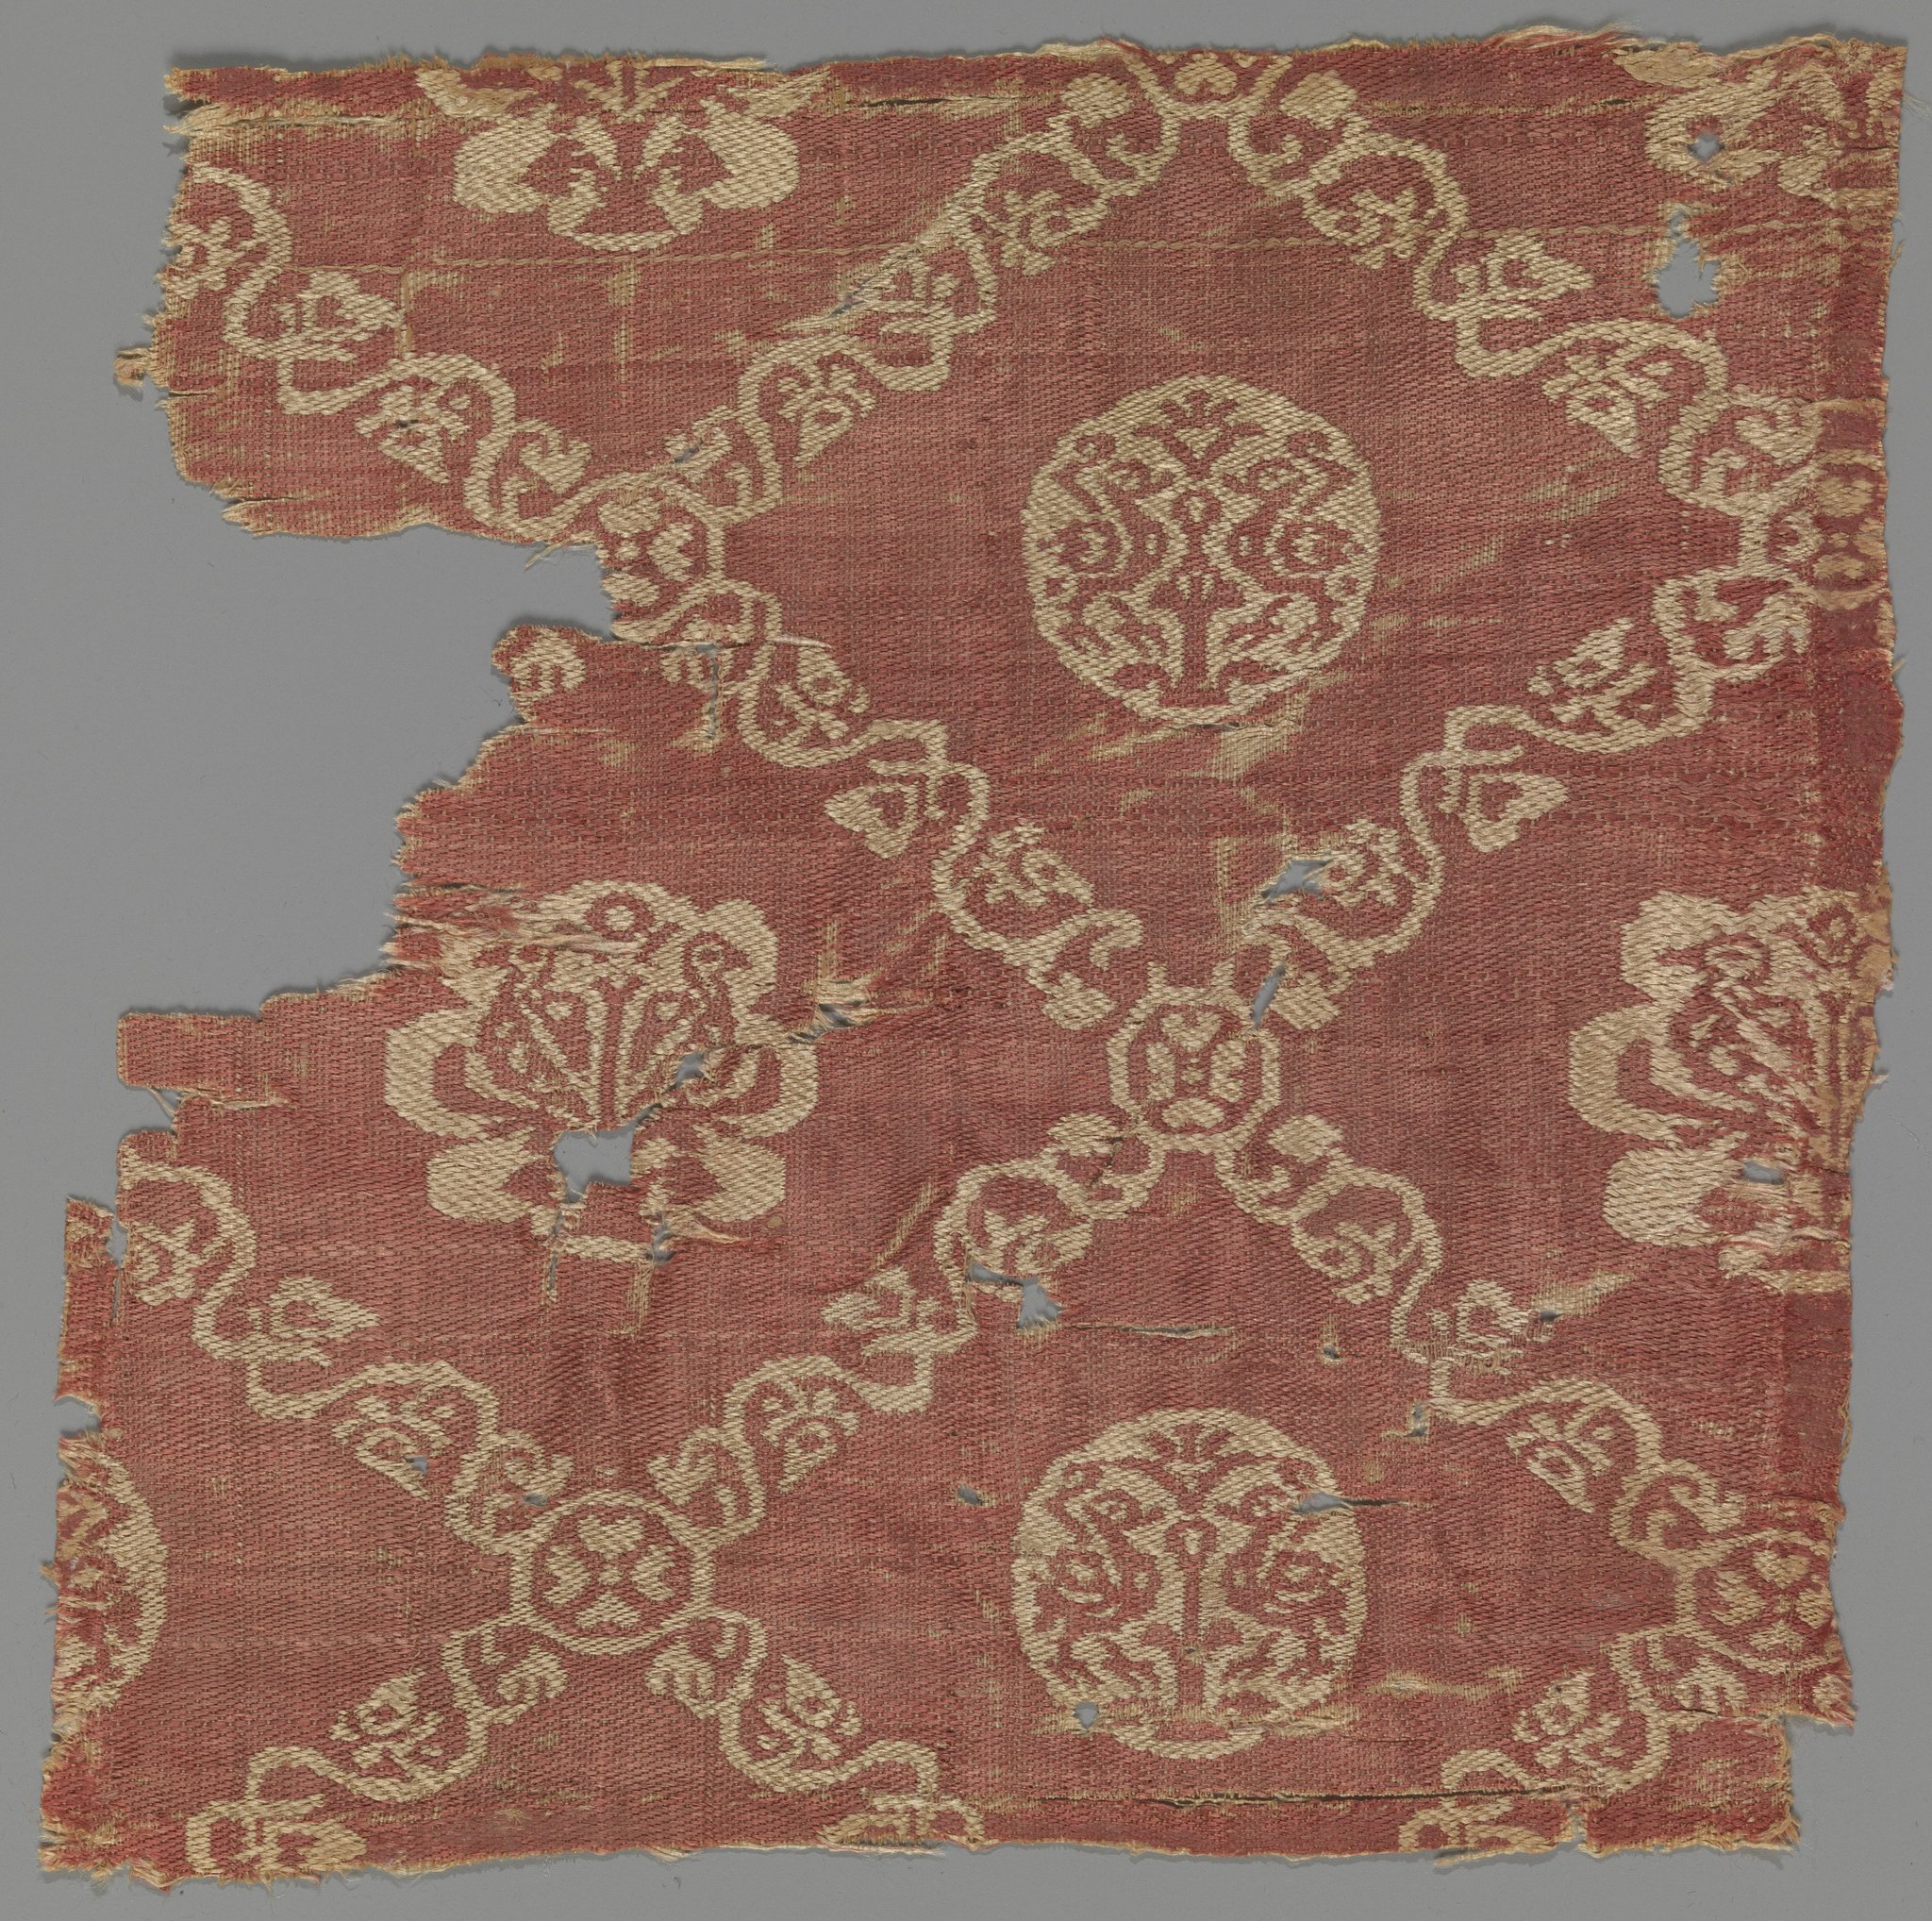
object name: textile fragment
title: Textile Fragment with Vine Lattice and Birds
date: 501-900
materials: silk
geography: egypt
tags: birds